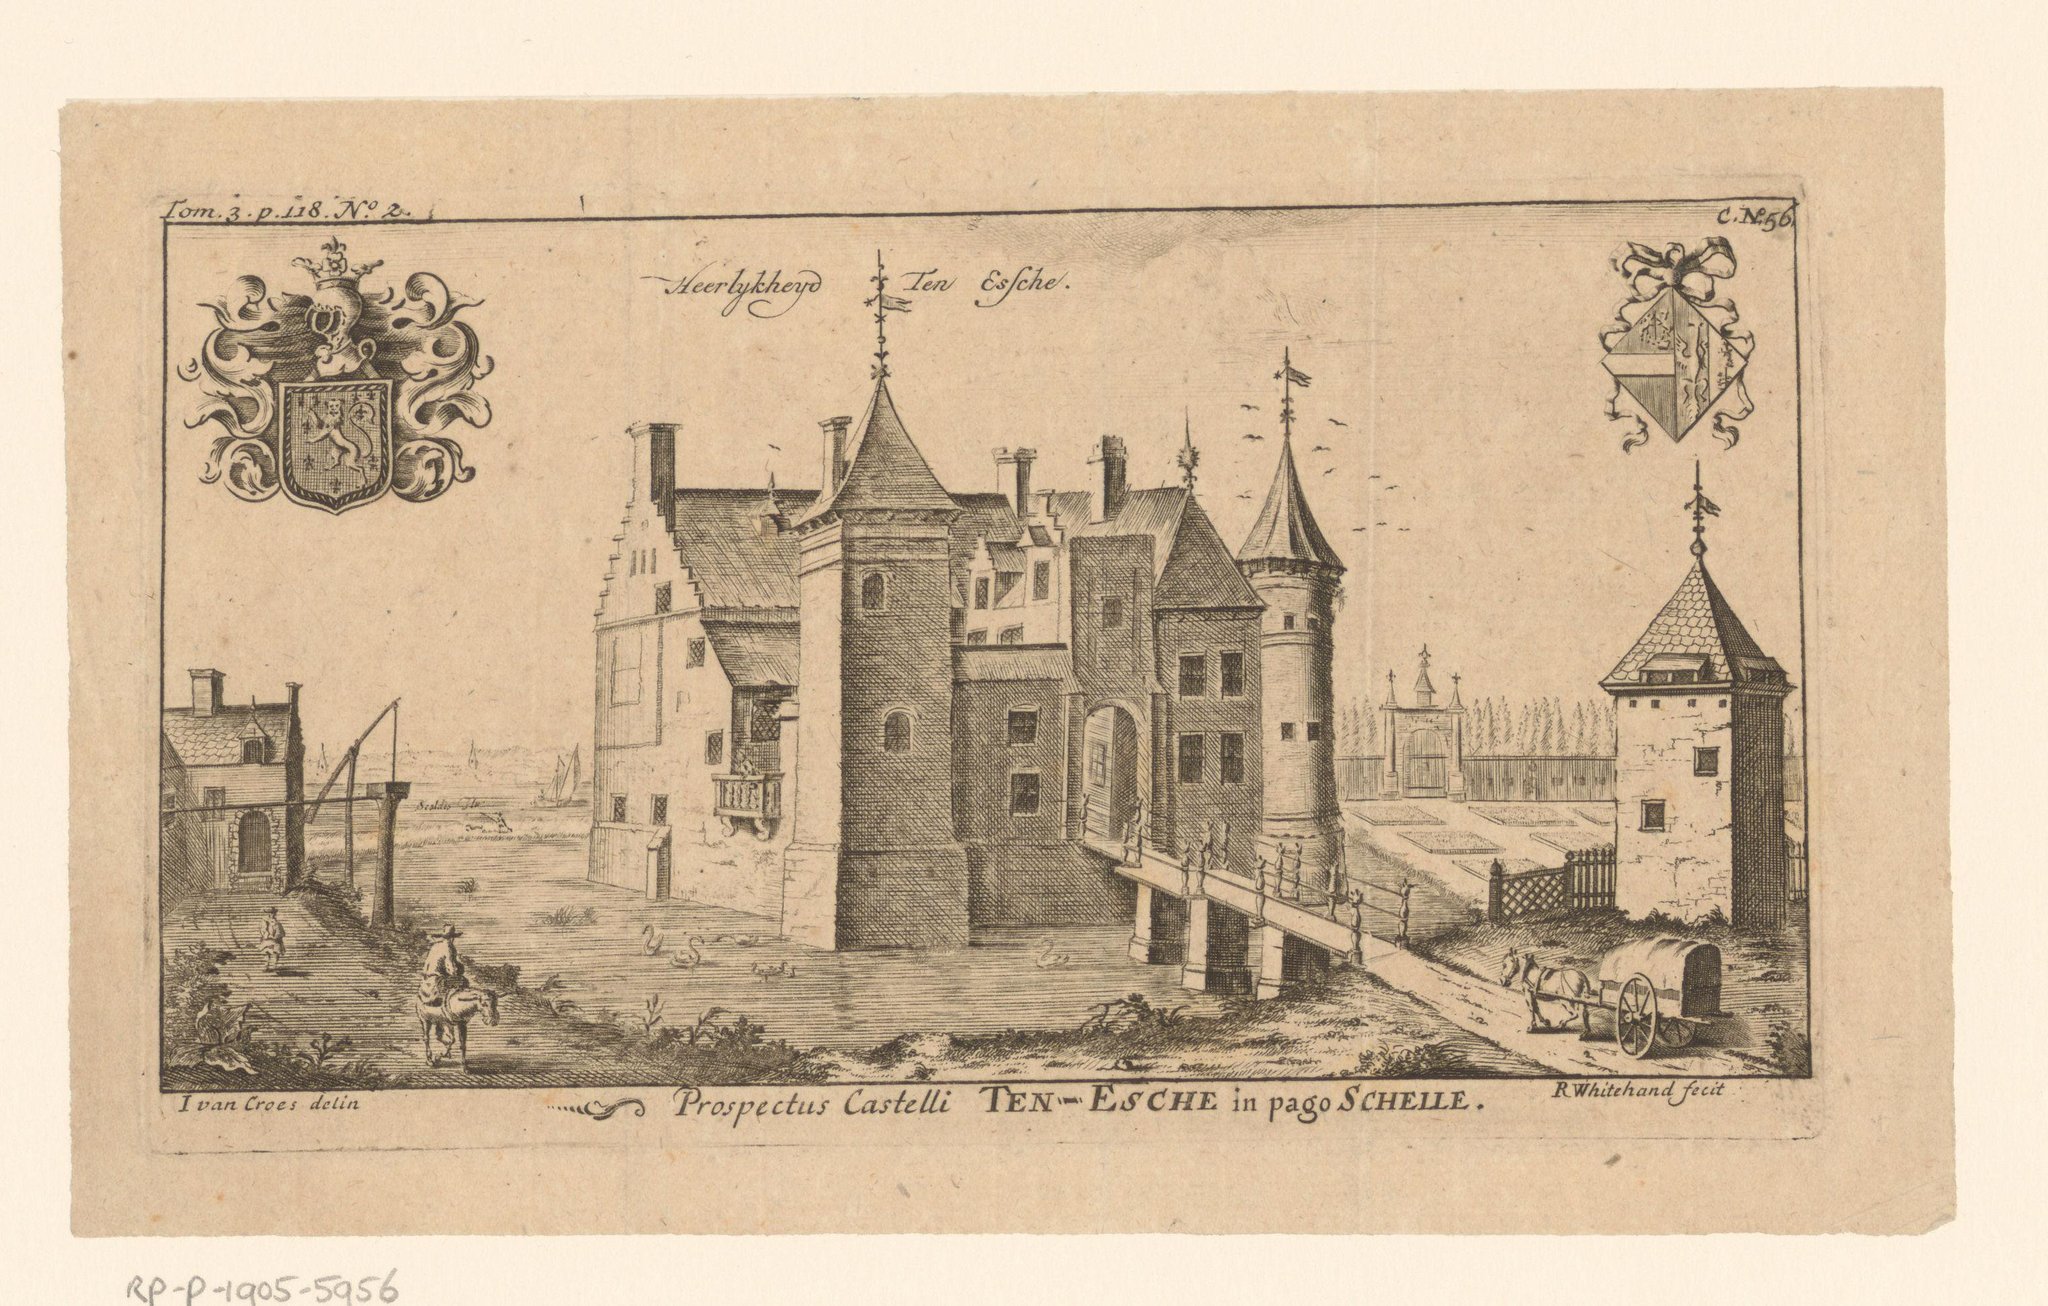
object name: print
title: Gezicht op Kasteel Ten Essche te Schelle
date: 1730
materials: paper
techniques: etching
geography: the hague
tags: castle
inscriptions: collector's mark: Lugt 2228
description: Eerdere staat gebruikt in: Le Roy, J. Groot wereldlijk tooneel des hertogdoms Braband. Den Haag: Christiaan van Lom, 1730. Deze latere staat uit onbekende (Franse?) publicatie.